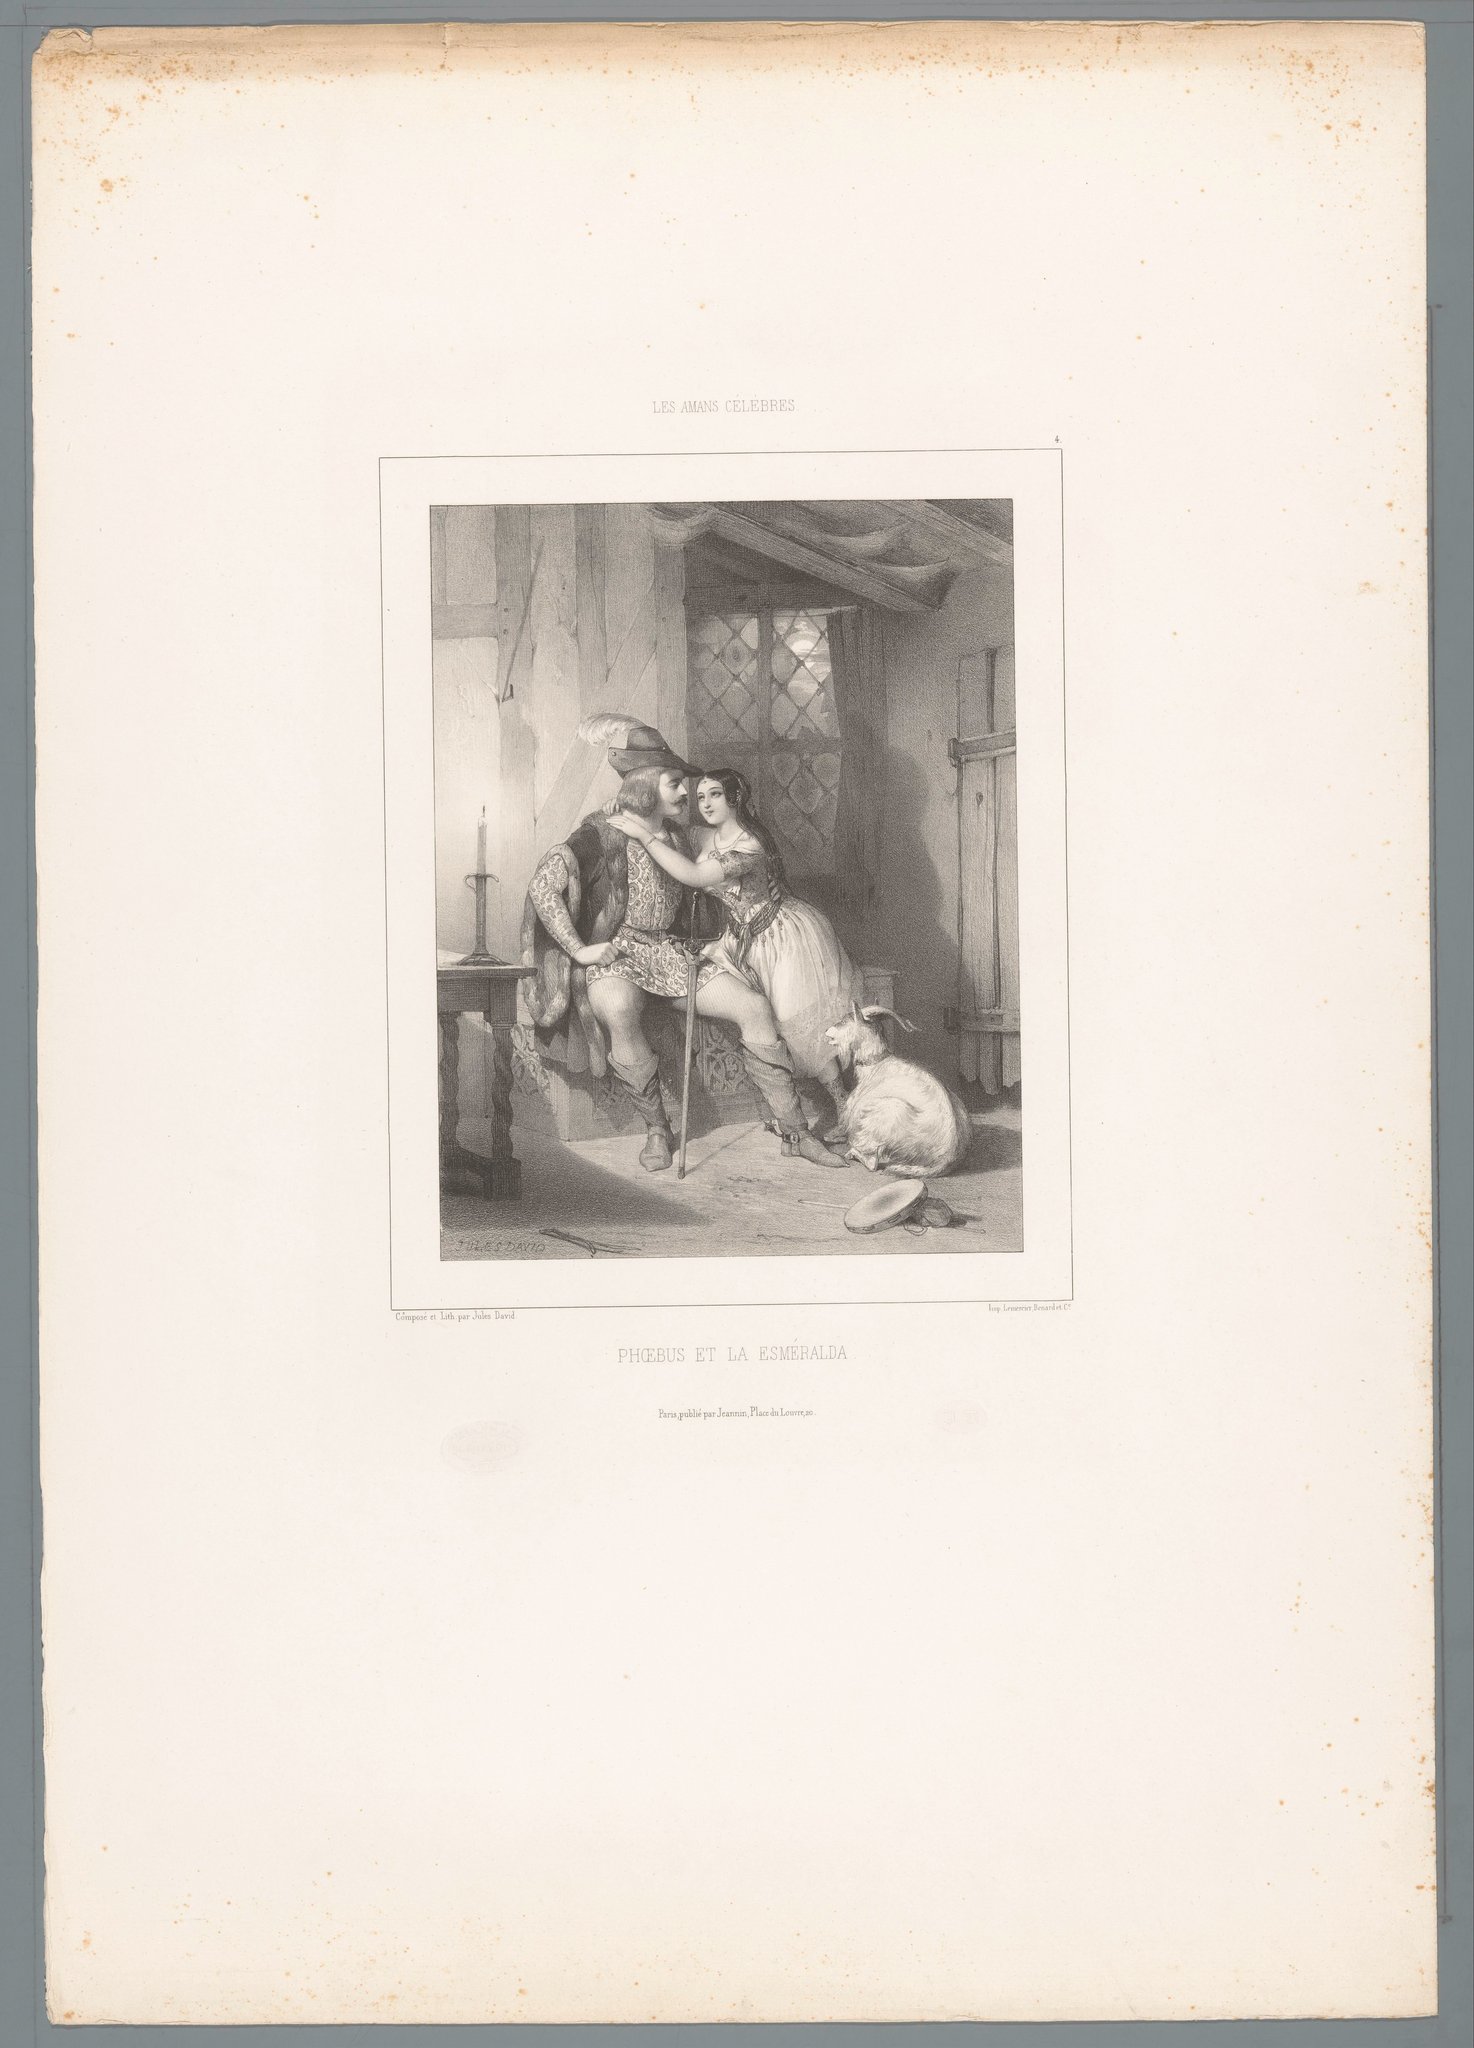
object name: print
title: Kapitein Phoebus en Esmeralda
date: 1841-1843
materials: paper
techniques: lithograph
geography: paris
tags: interior of the house, goat, couple of lovers, paris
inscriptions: check stamp: Lugt 3903, check stamp: Lugt 1397c, collector's mark: Lugt 2228a